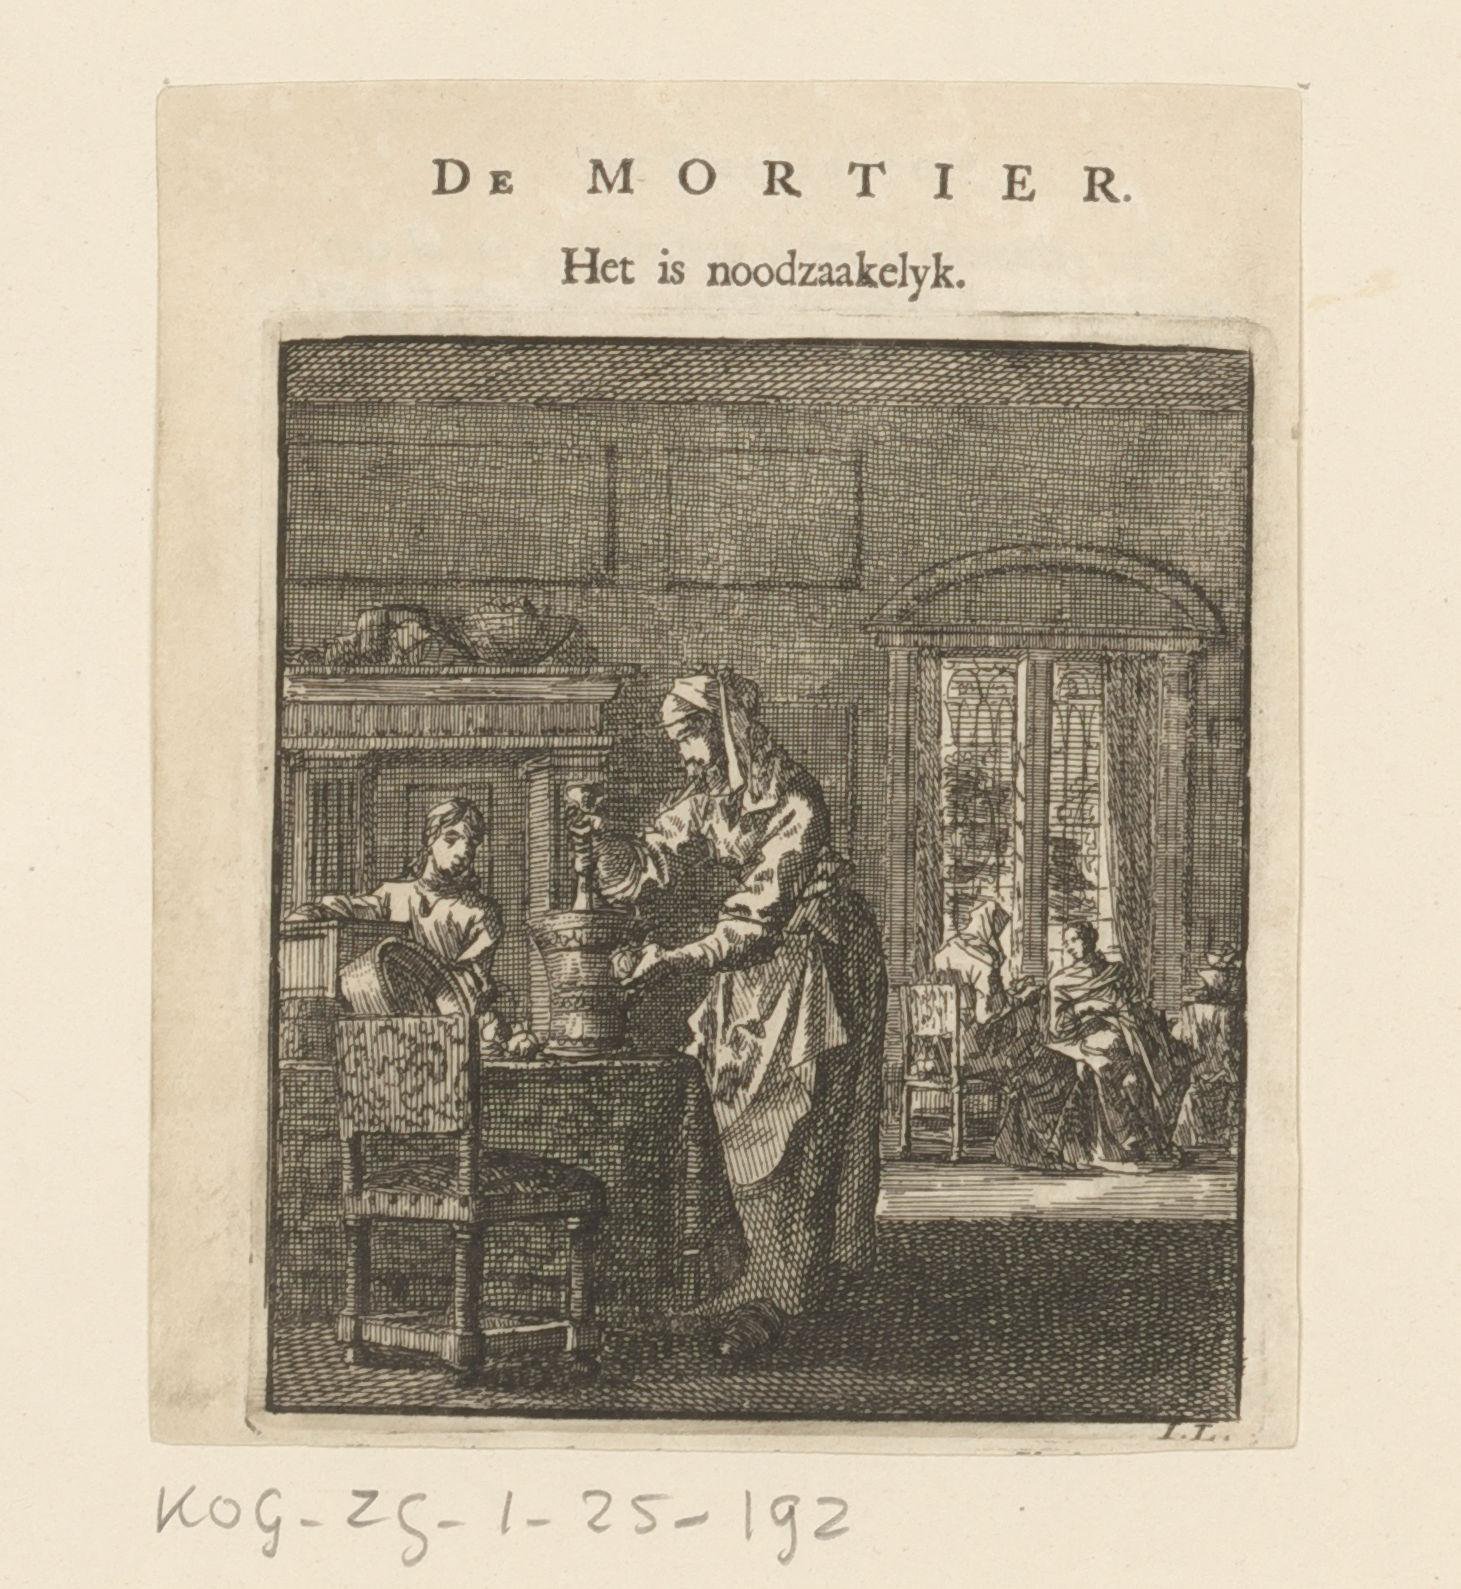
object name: print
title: De Mortier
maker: jan luyken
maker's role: draughtsman, print maker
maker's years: 1649-1712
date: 1711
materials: paper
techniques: etching, letterpress printing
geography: amsterdam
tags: pestle and mortar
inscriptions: stamp, collector's mark: Lugt 1641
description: Prent uit: Luyken, Jan. Het leerzaam huisraad, vertoond in vyftig konstige figuuren, met godlyke spreuken en stichtelyke verzen. Amsterdam: weduwe Pieter Arentsz. II en Cornelis van der Sys, 1711, p. 104.